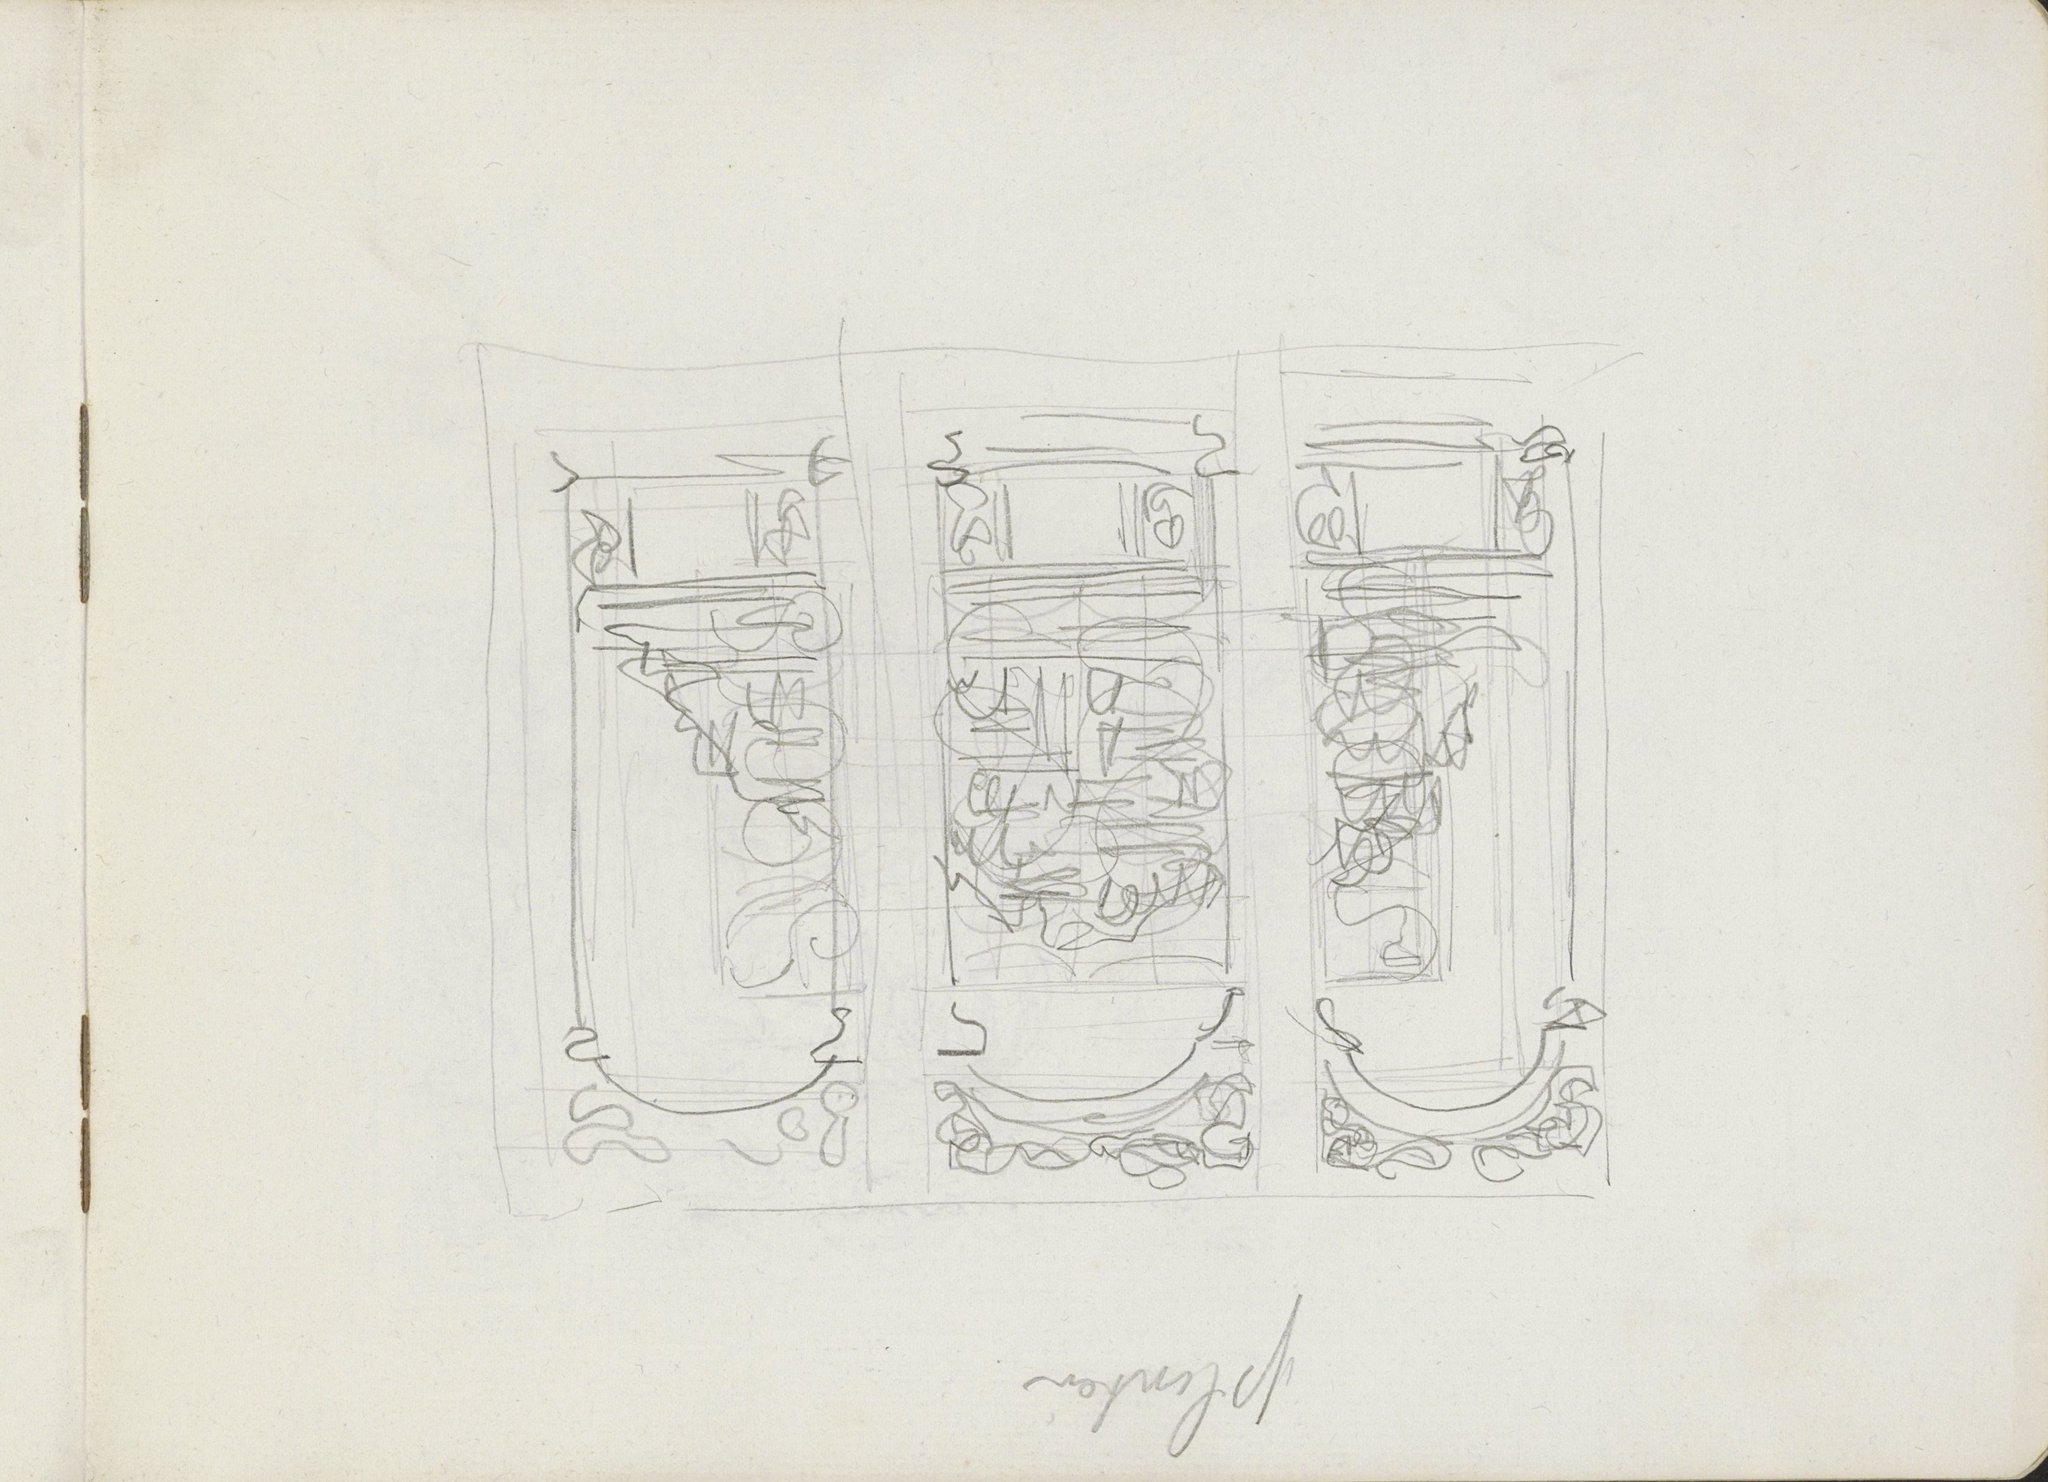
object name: sketchbook leaf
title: Ontwerpen voor plinten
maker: carel adolph lion cachet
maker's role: draughtsman, print maker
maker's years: 1864-1945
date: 1905-1910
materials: paper, pencil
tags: architectural detail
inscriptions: annotation: ‘plinten’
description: Blad 17 recto uit een schetsboek met 27 bladen.